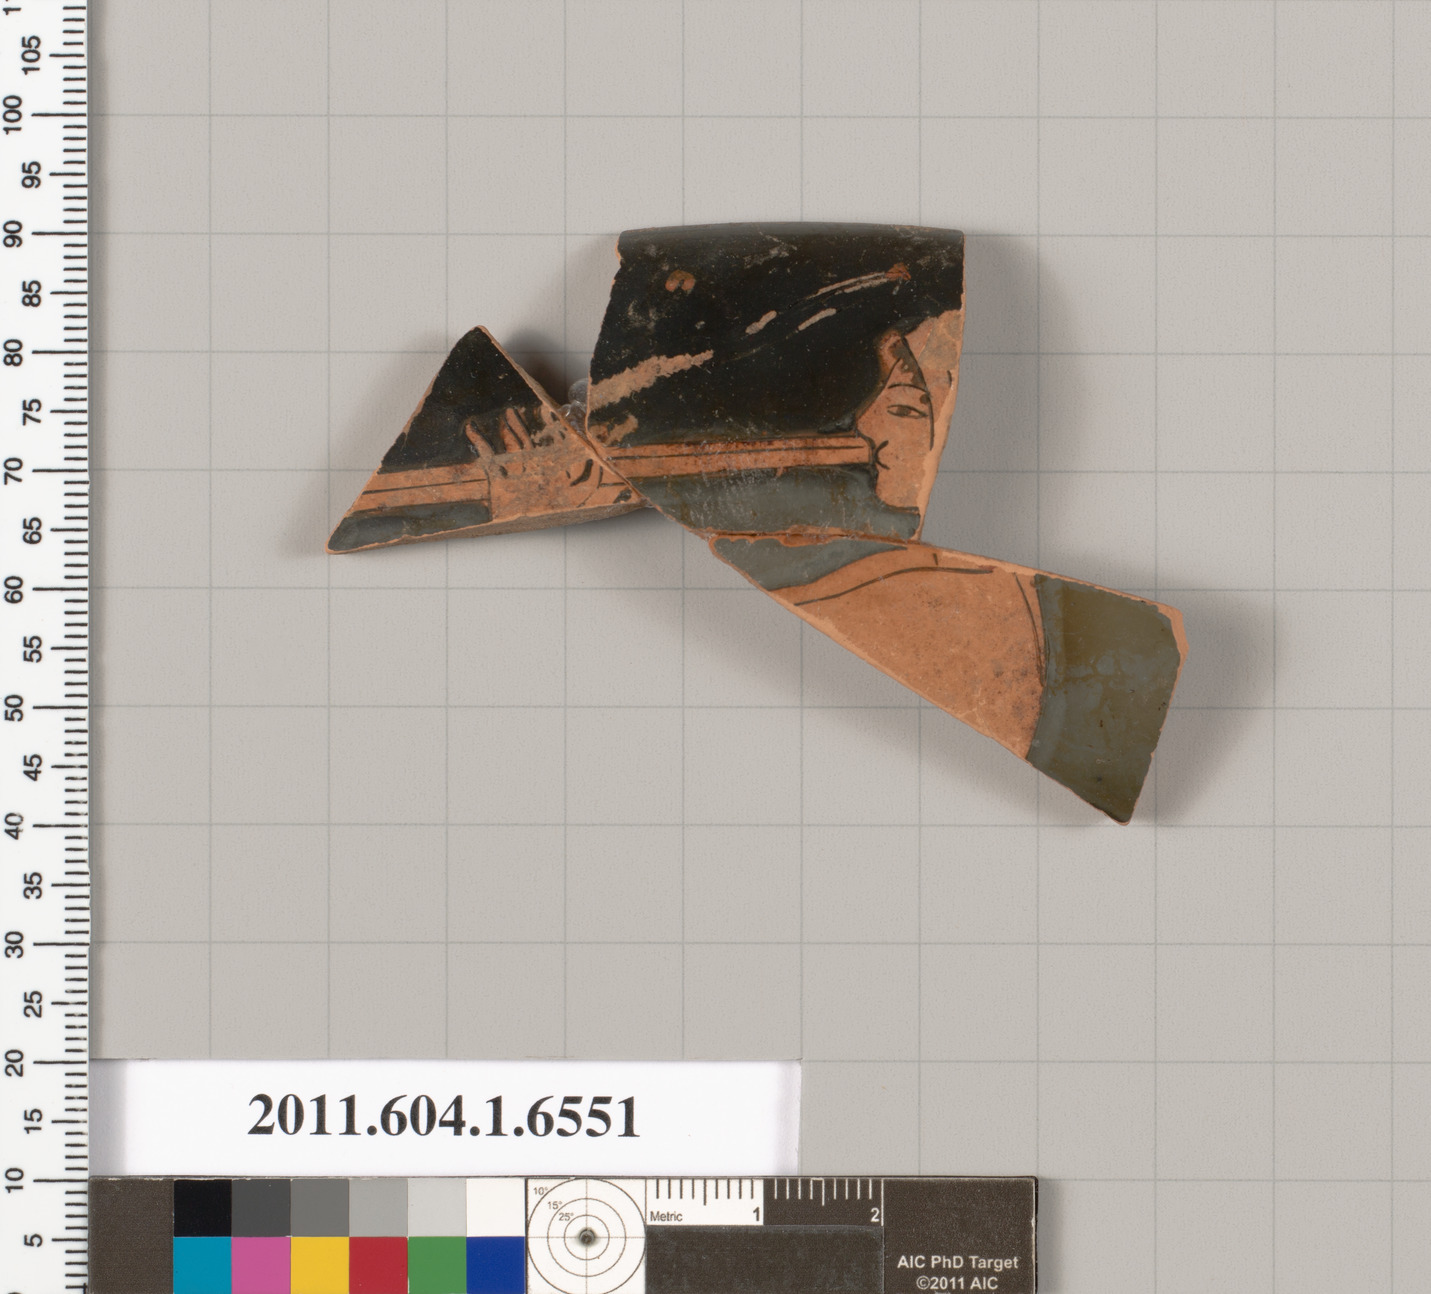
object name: kylix fragment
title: Terracotta rim fragment of a kylix (drinking cup)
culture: greek, attic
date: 490-480 BCE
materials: terracotta